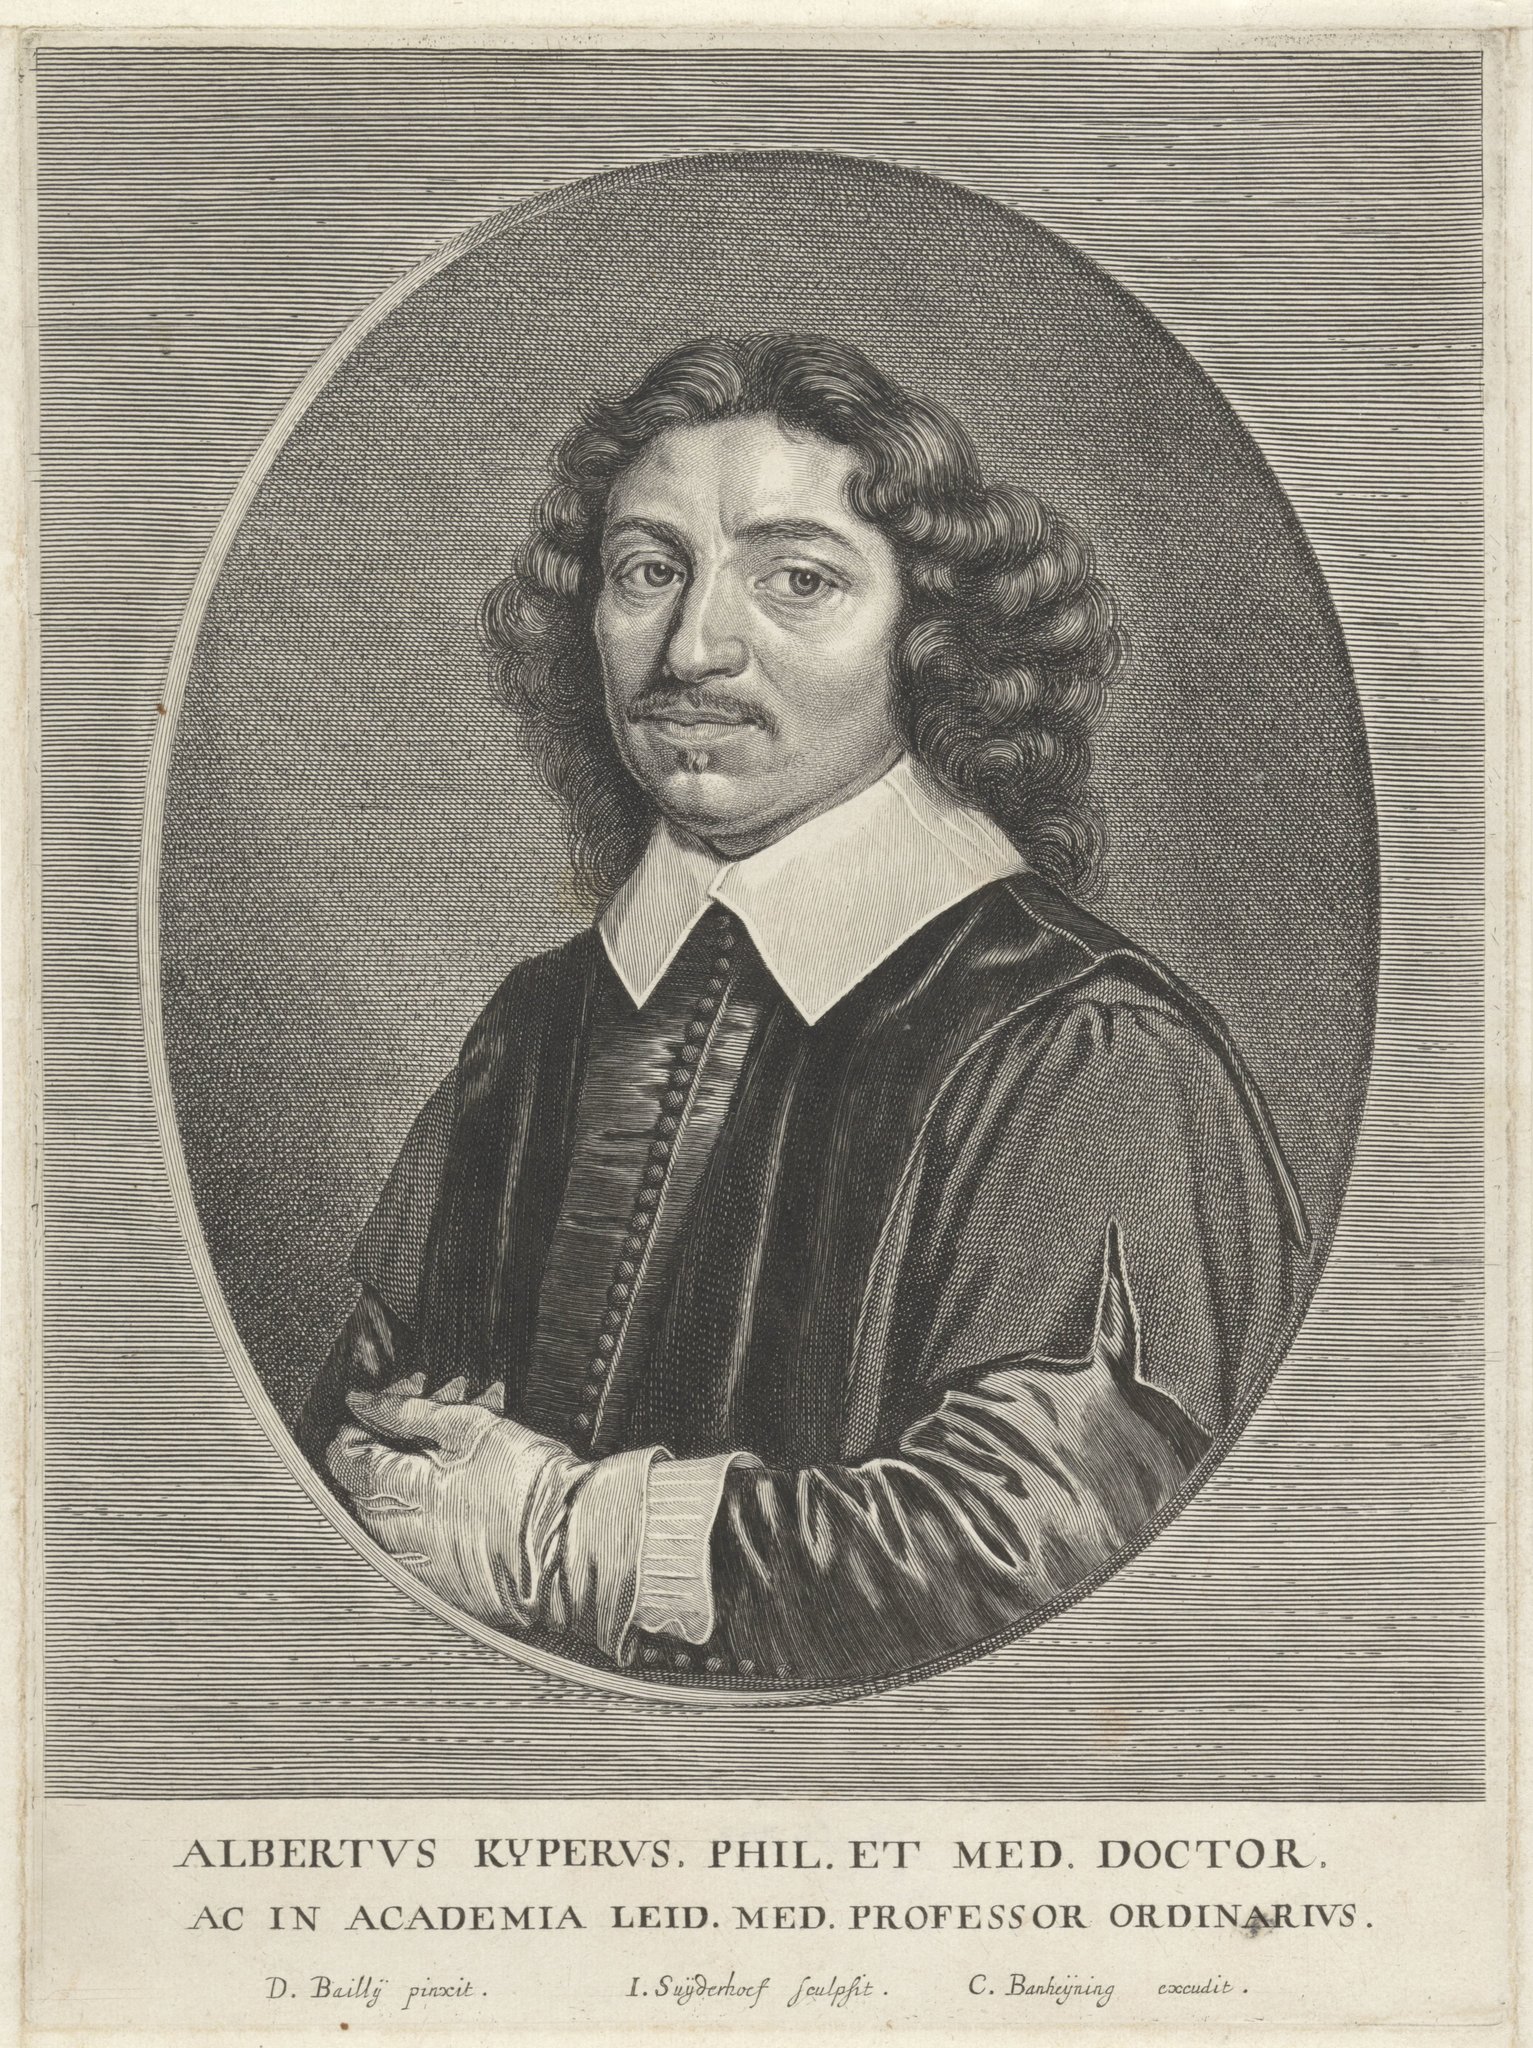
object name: print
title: Portret van Albert Kijper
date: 1650-1665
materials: paper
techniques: engraving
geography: haarlem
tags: professor (+ portrait of teacher, professor)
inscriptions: collector's mark: Lugt 240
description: Portret van Albert Kijper, hoogleraar geneeskunde en filosofie aan de universiteit van Leiden. Onderaan in de marge zijn naam en functie in het Latijn.